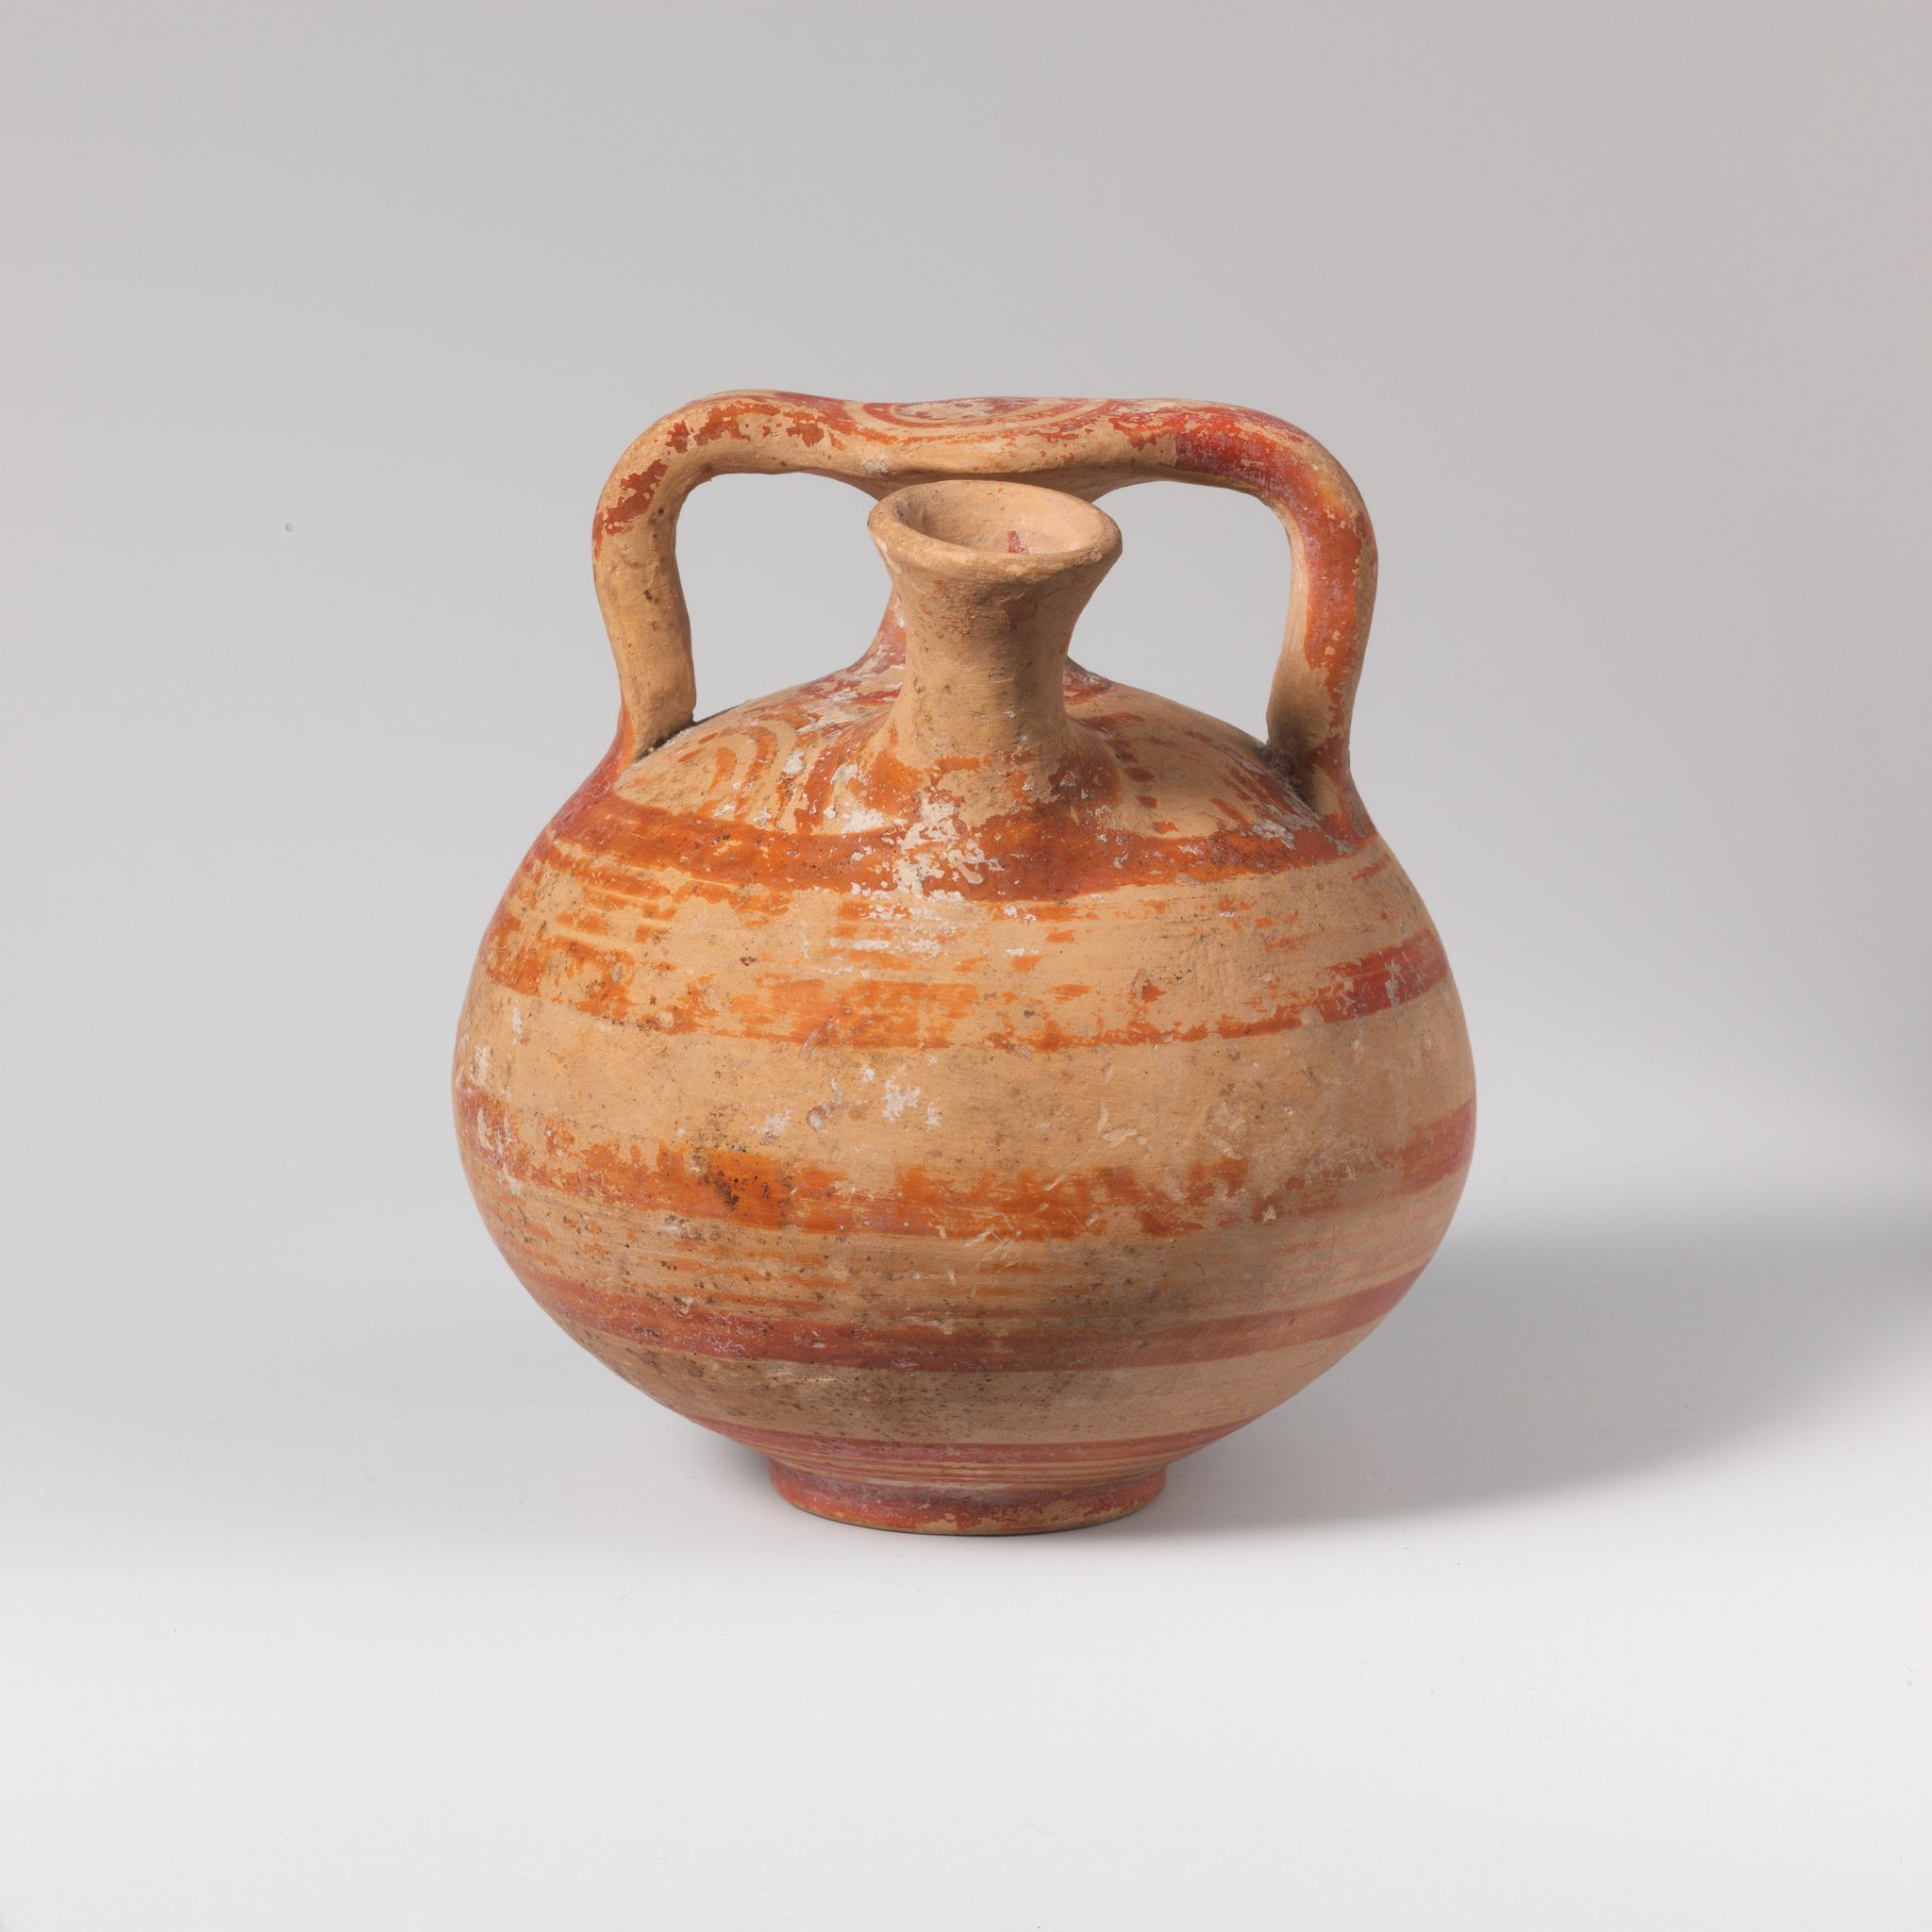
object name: stirrup jar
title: Terracotta stirrup jar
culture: mycenaean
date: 1400-1050 BCE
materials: terracotta